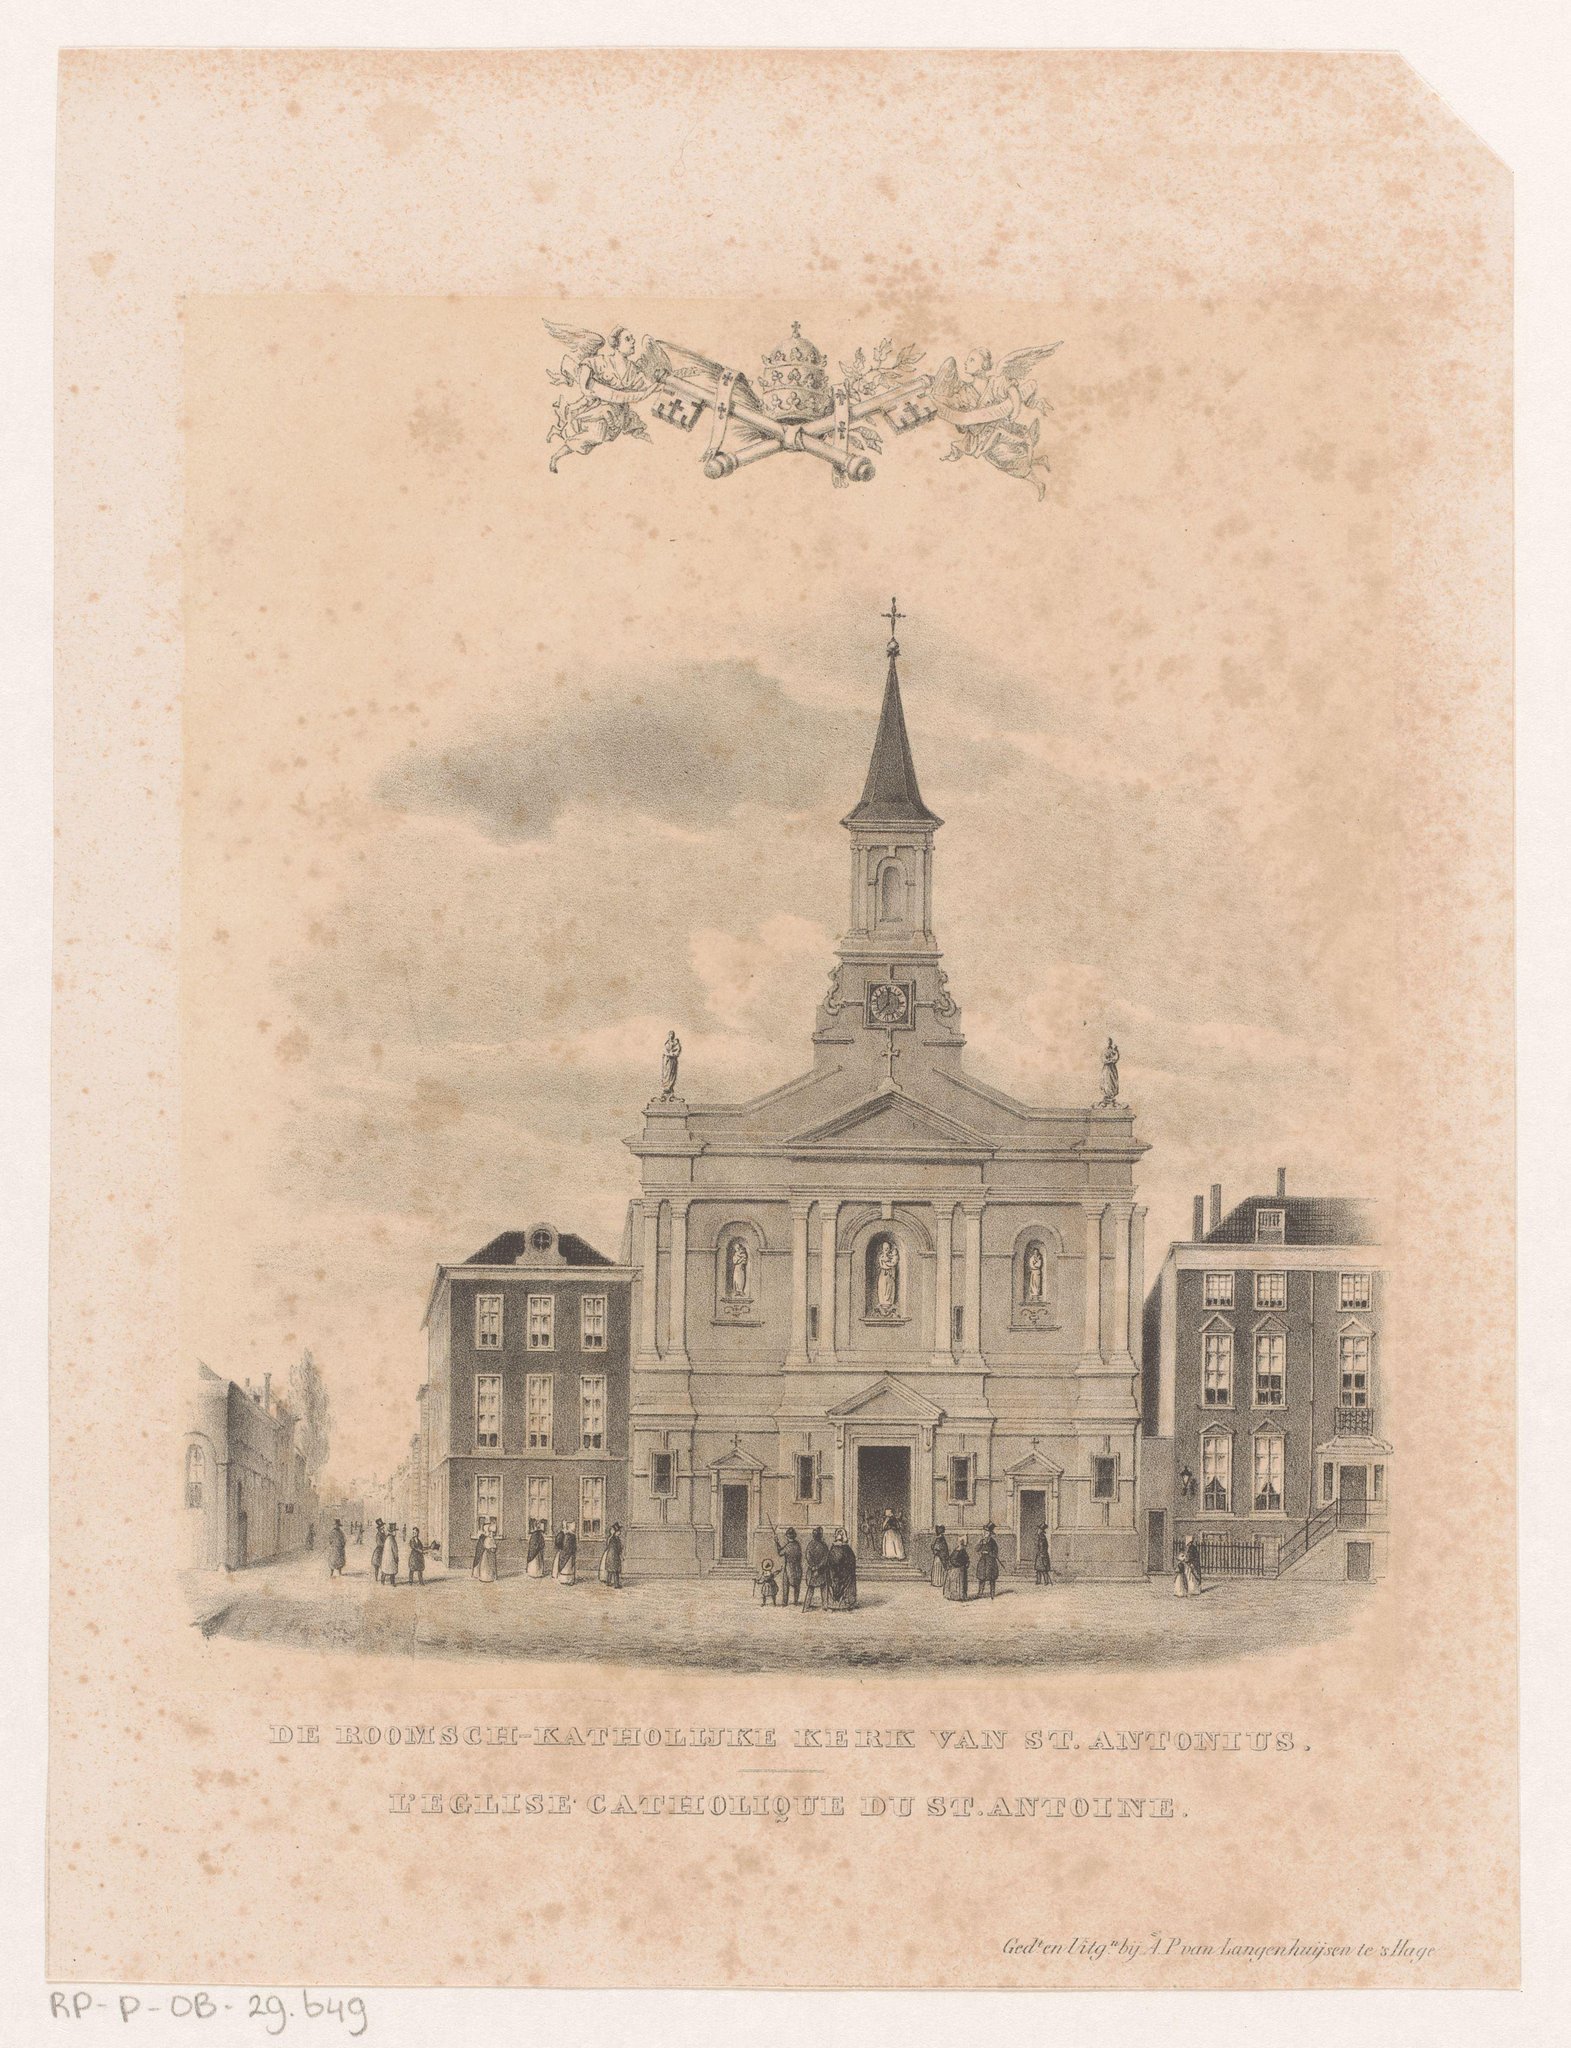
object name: print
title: De Roomsch-Katholieke kerk van St. Antonius / L'Eglise Catholique du St. Antoine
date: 1830-1846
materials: paper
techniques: tone lithography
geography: the hague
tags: church (exterior), the hague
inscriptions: collector's mark: Lugt 2228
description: Mensen op straat voor de oude Sint-Antonius van Paduakerk, ook wel Boskantkerk genoemd.